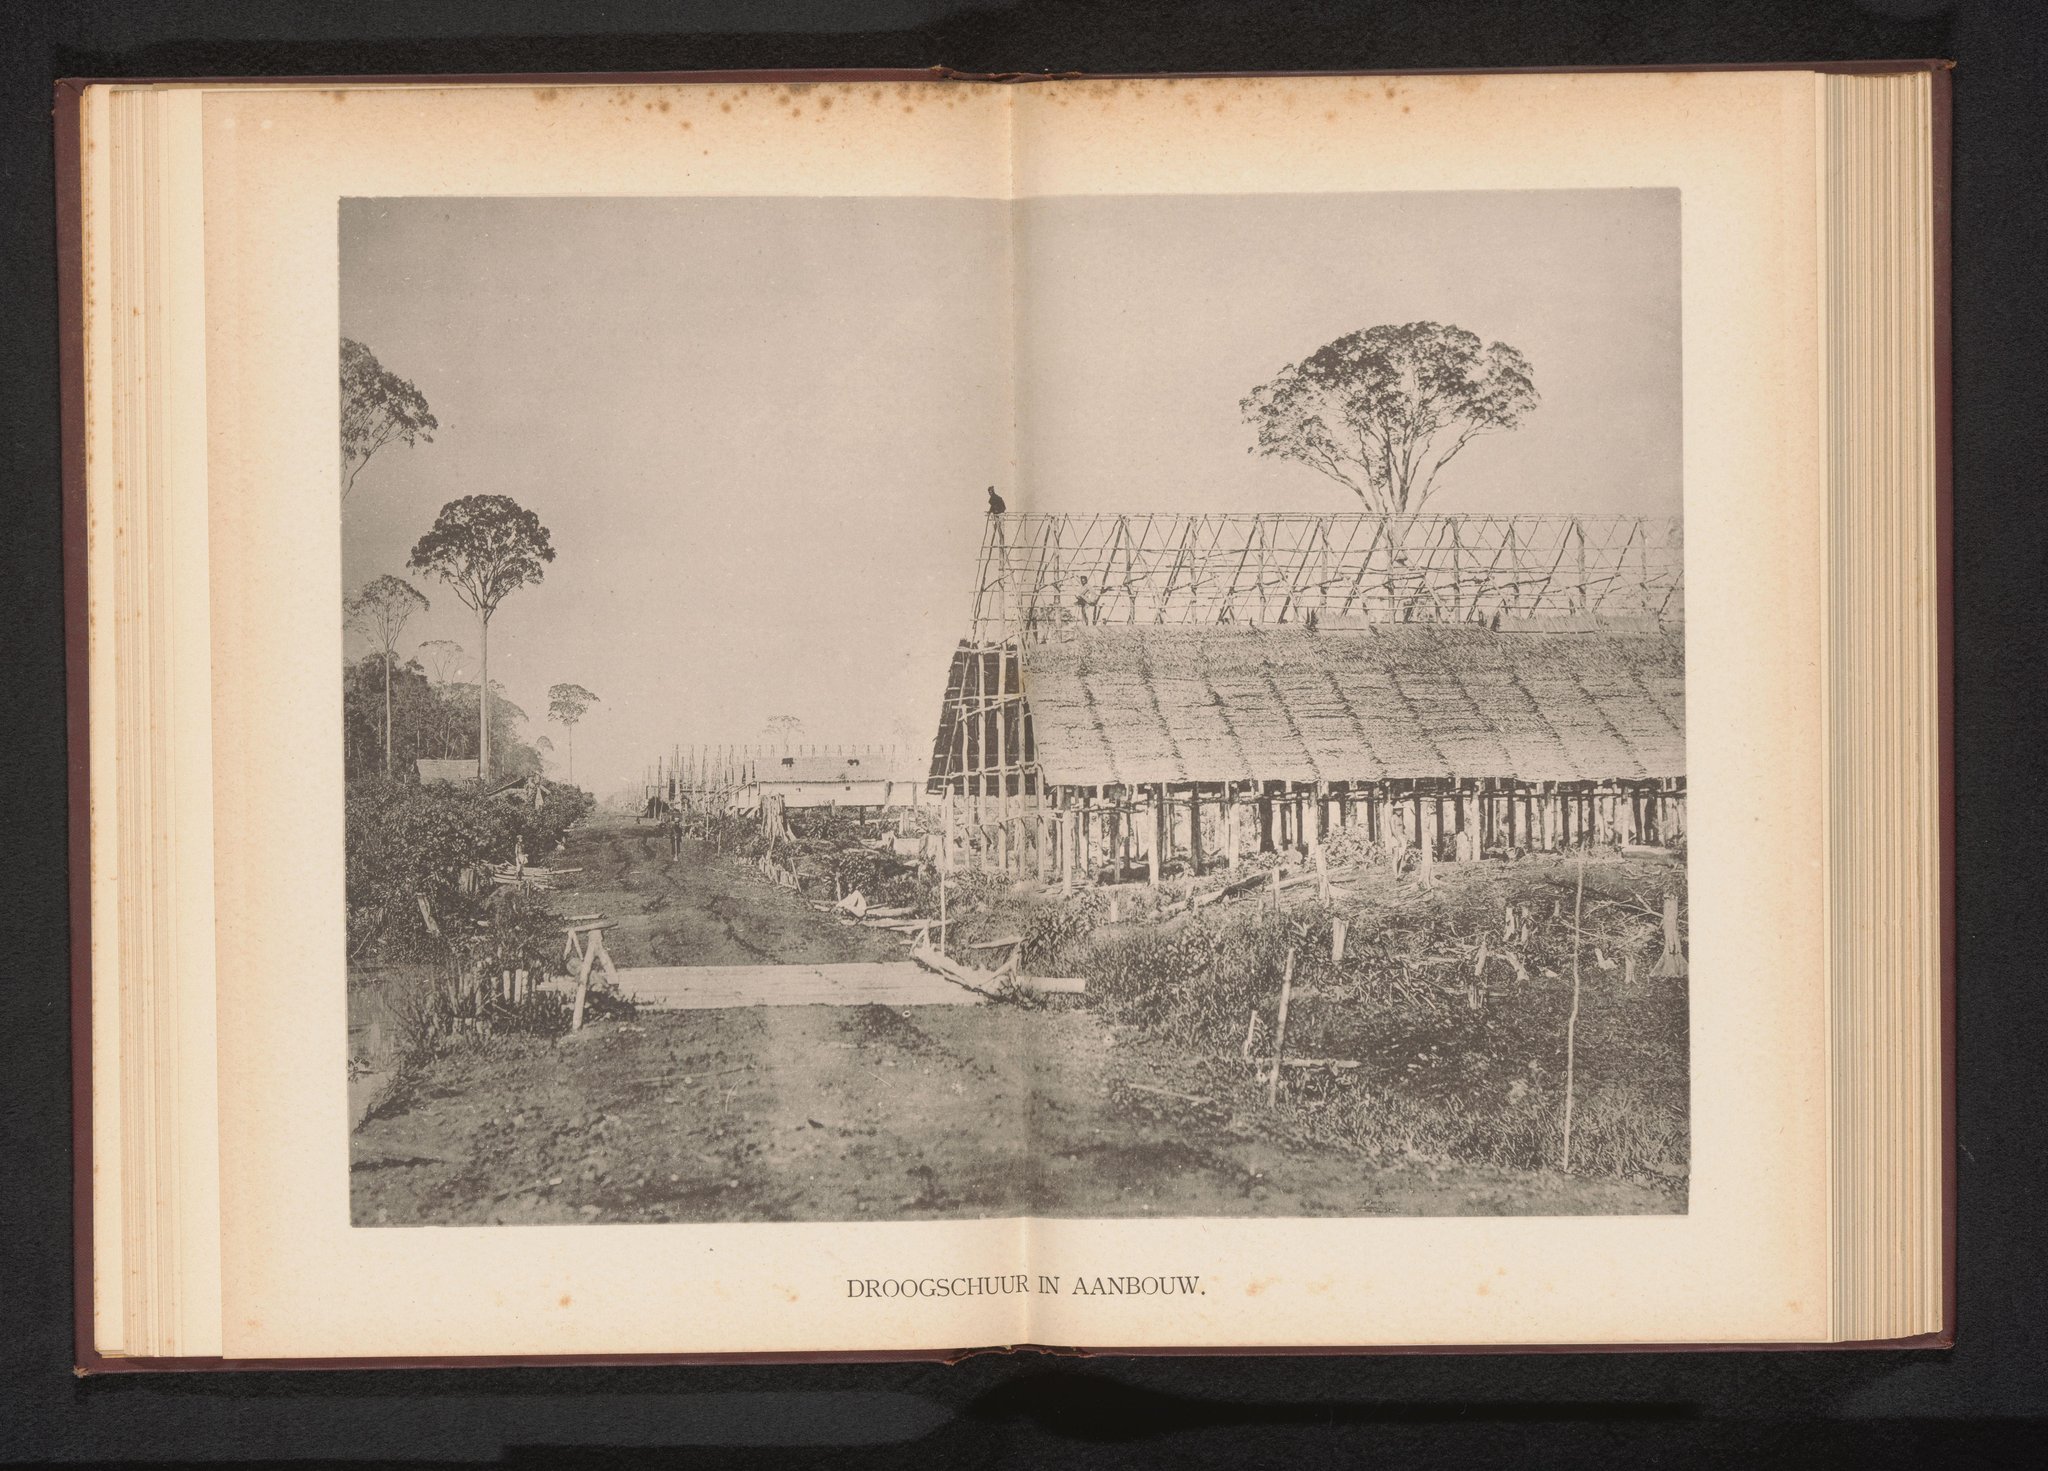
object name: photomechanical print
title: Droogschuur voor tabak op een tabaksplantage in Deli, Sumatra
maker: Anonymous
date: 1884-1889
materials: paper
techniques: photograph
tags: large-scale structure for storage, e.g.: warehouse, depot, silo, plantation, tobacco, sumatra